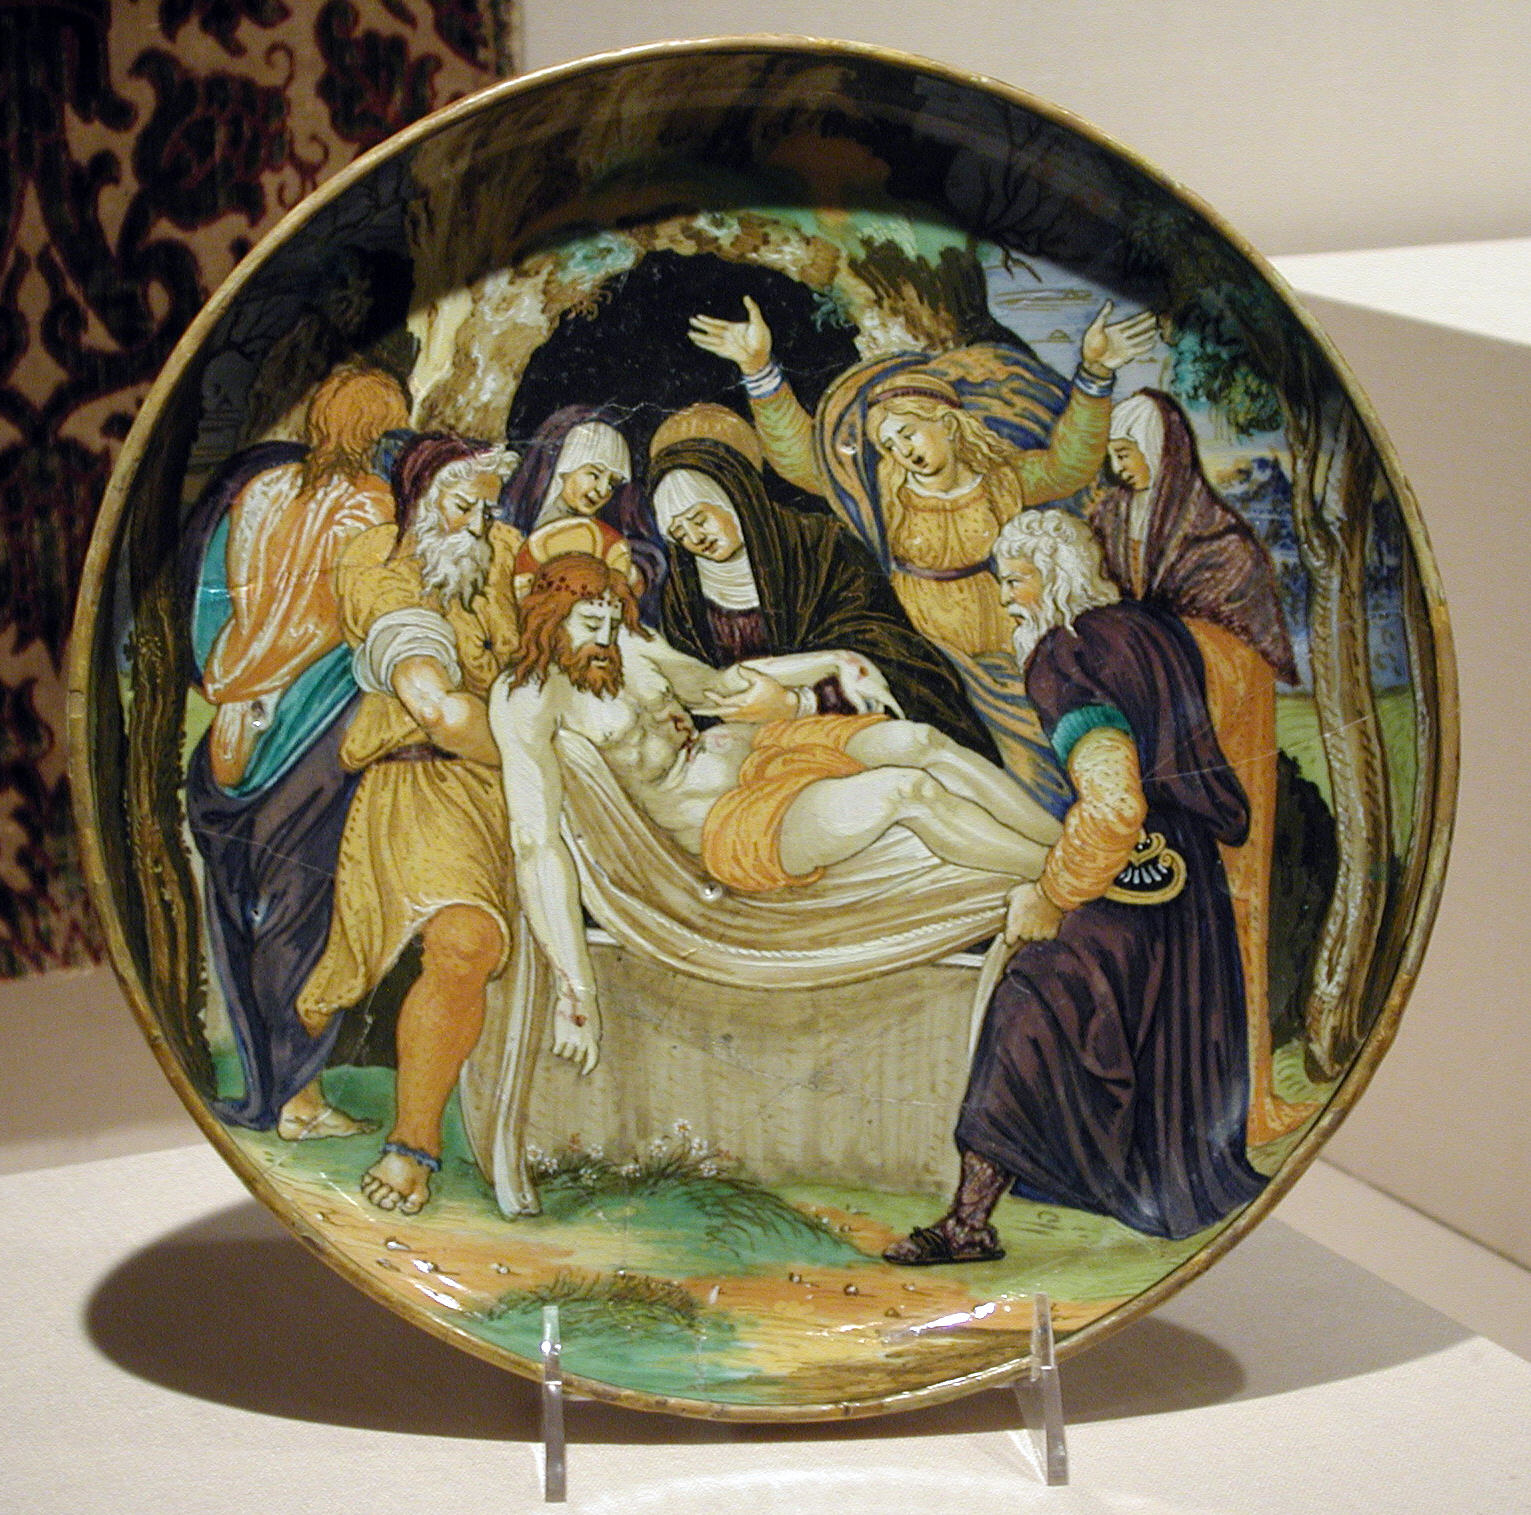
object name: tazza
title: The Entombment of Christ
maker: fra xanto avelli da rovigo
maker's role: artist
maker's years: 1486-1582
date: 1536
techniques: maiolica, glazing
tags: sadness,men,women,christ,entombment